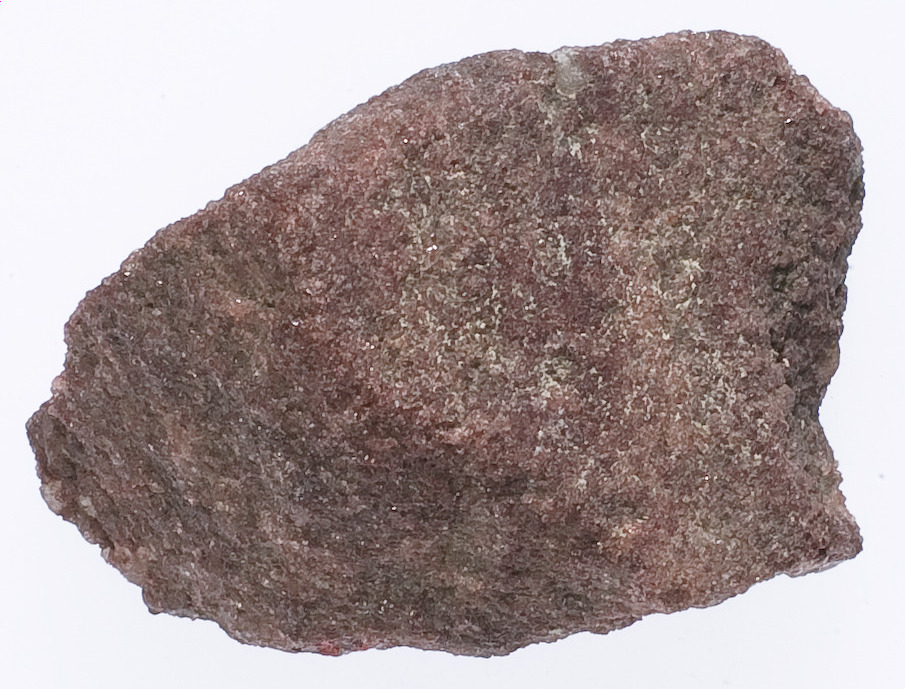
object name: chip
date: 1353-1336 BCE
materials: quartzite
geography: egypt